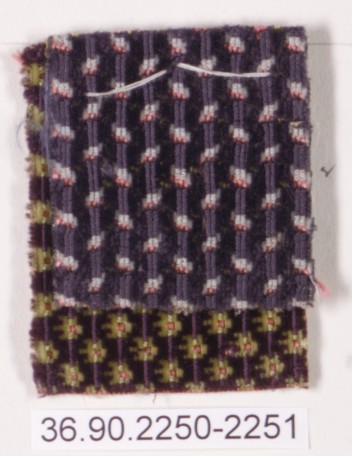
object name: piece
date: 1801-1900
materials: silk